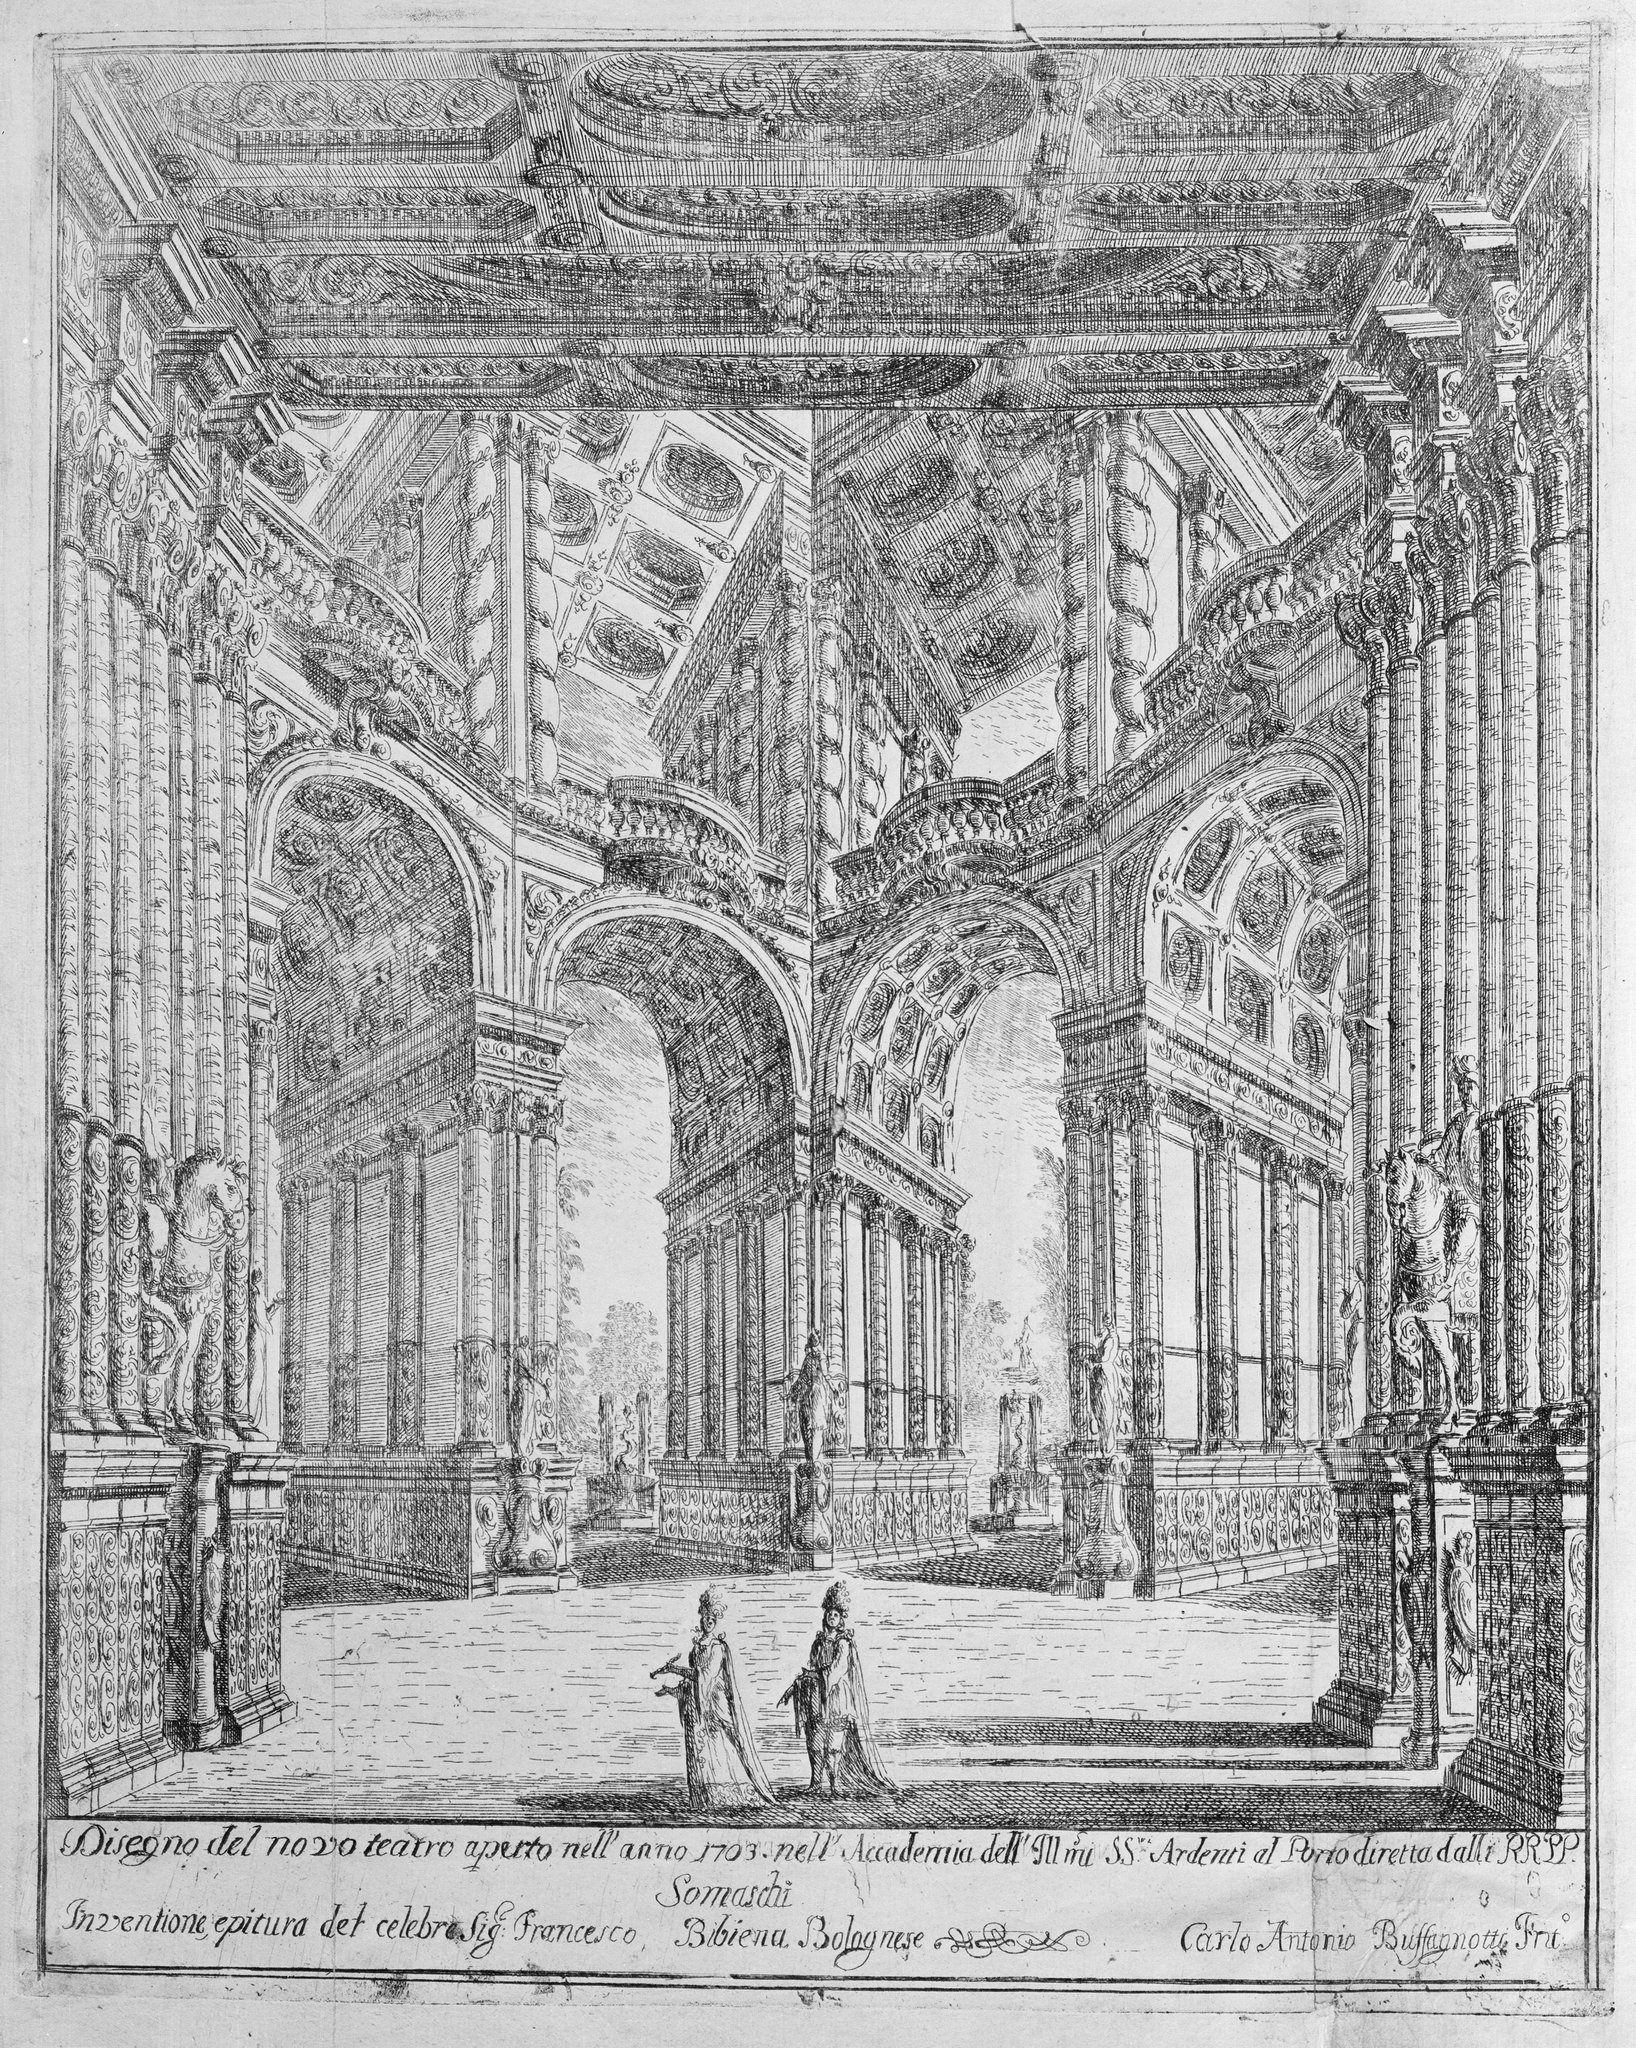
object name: book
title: Varie opere di Prospettive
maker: ferdinando galli bibiena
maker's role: designer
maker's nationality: italian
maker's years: 1657-1743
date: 1703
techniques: engraving, printing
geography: italy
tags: architecture,arches